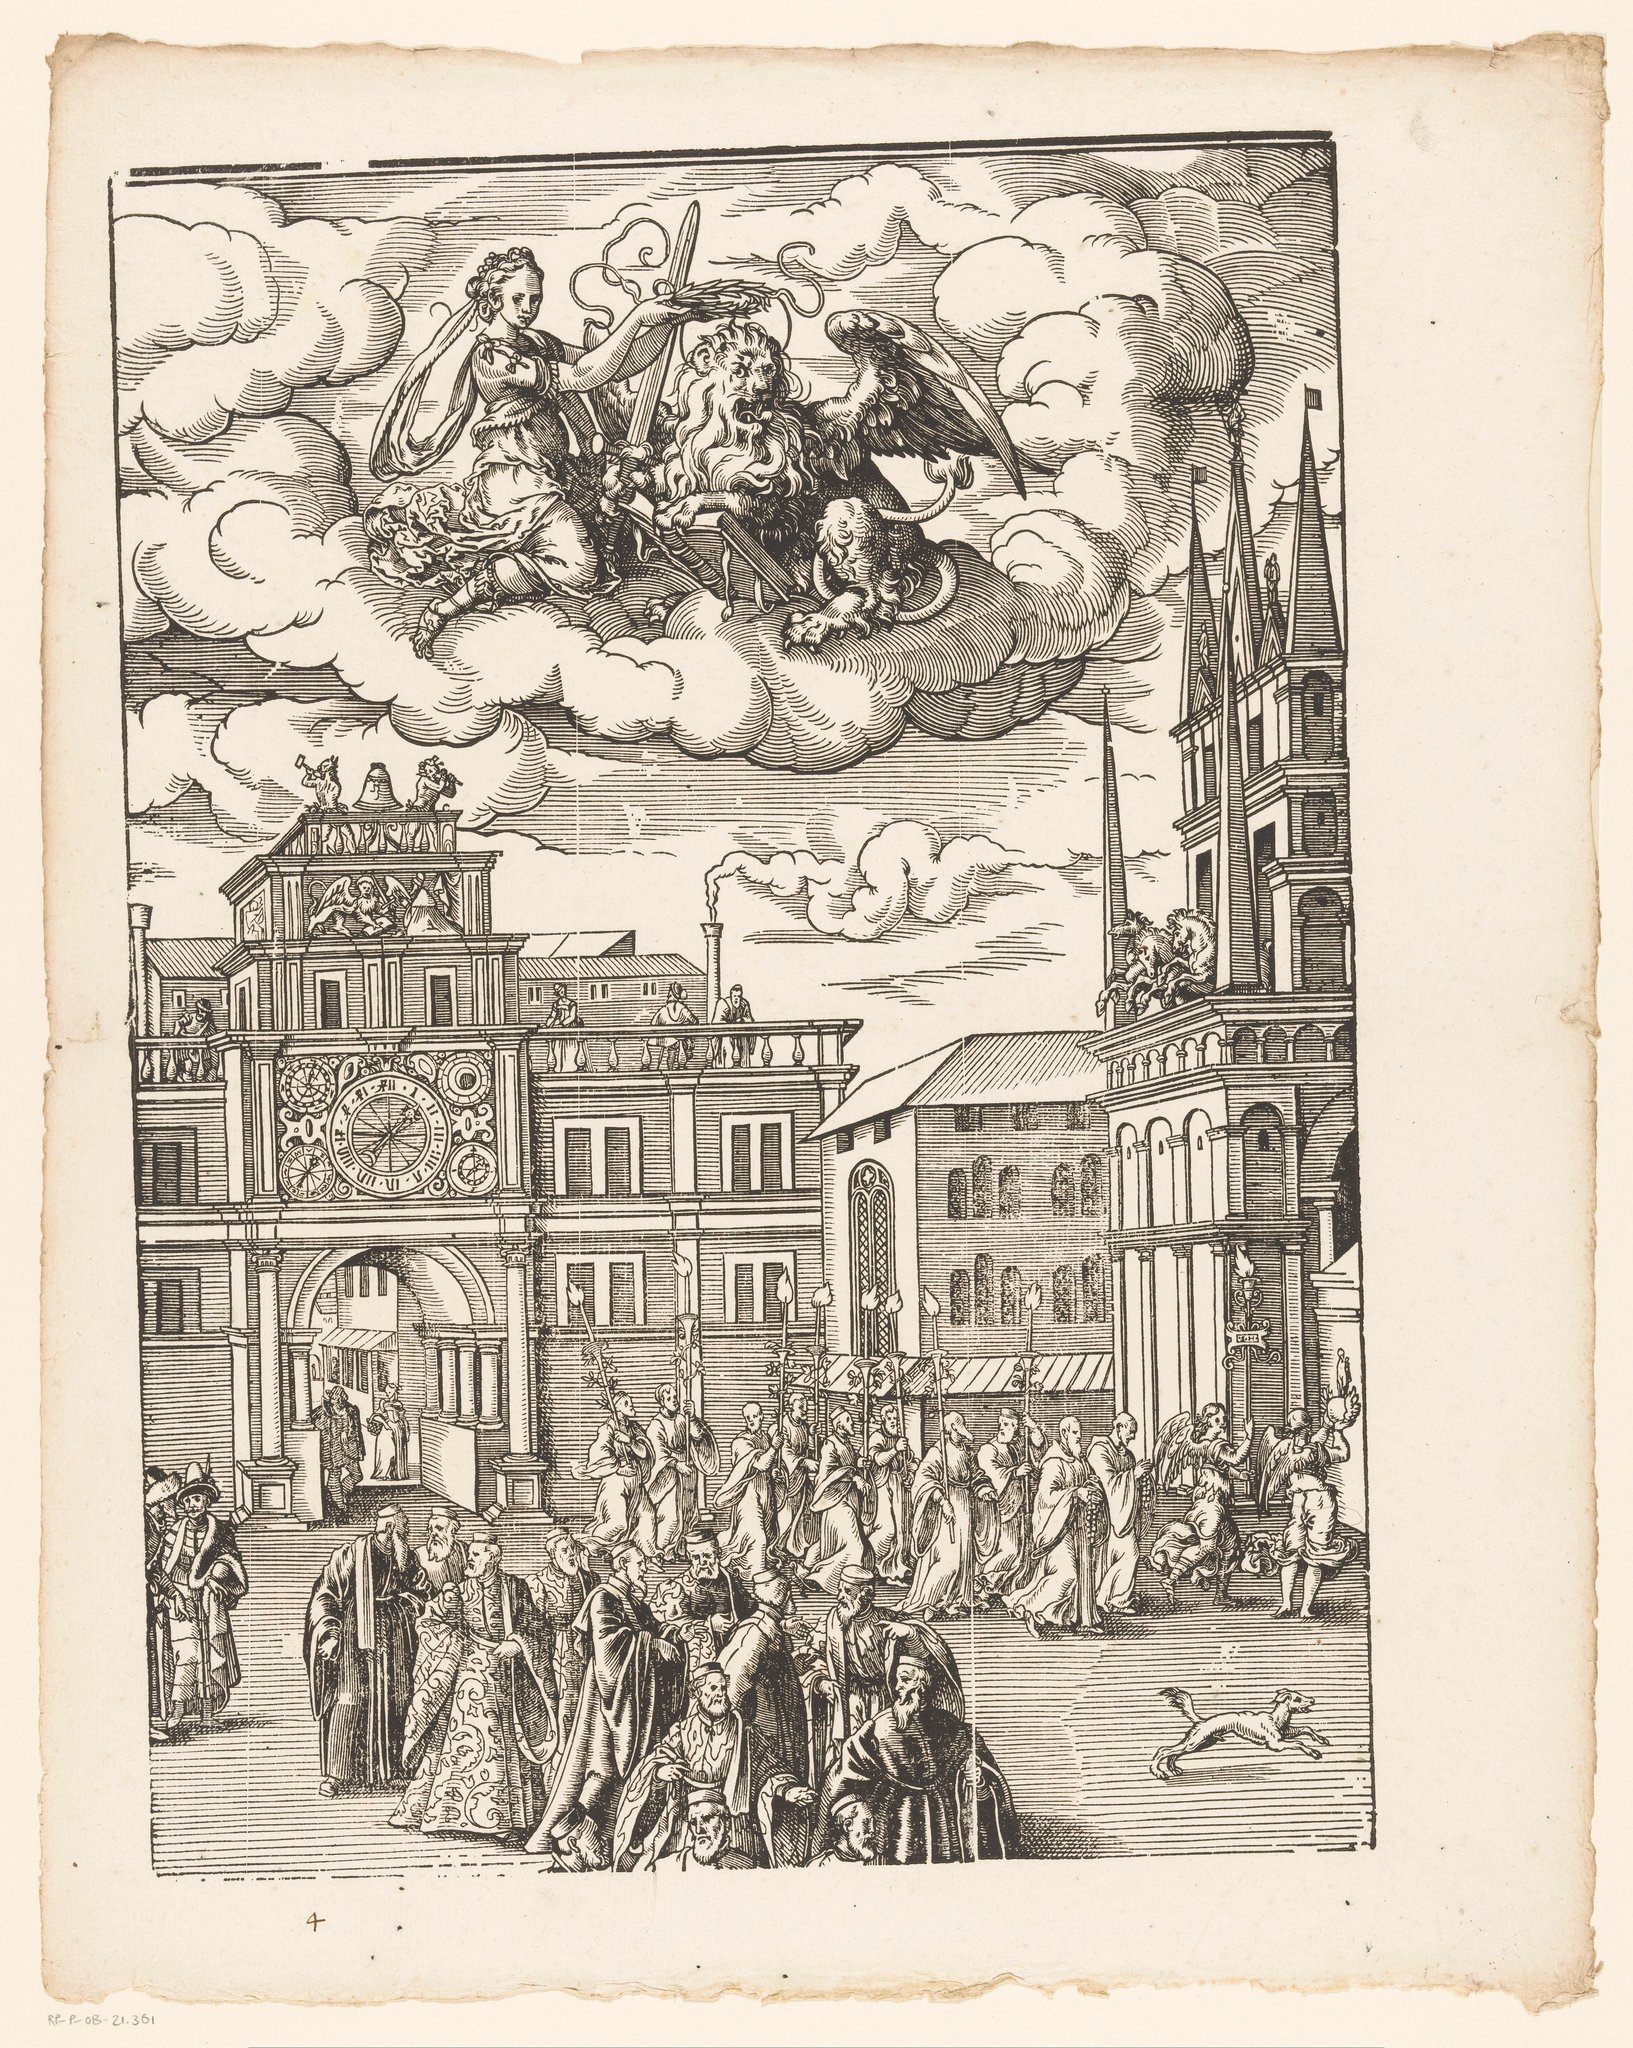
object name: print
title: Festa della Sensa (vierde gedeelte)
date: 1679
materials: paper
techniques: woodcut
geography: nuremberg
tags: city-view in general; 'veduta', lion (possibly with book) ~ symbol of st. mark, church (exterior), clock, procession ~ christian religion, gondola, venice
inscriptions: number: ‘4’, collector's mark: Lugt 240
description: Vierde gedeelte van een grote voorstelling van de Festa della Sensa. De voorstelling is gedrukt van veertien blokken, de titel van vijf blokken en het onderschrift bestaat uit vijf delen van elk drie kolommen Duits tekst. In de collectie Rijksmuseum bevinden zich twee complete exemplaren inclusief titel en onderschrift. De veertien blokken die samen de voorstelling vormen zijn in de titels met de klok mee vanaf linksboven genummerd.